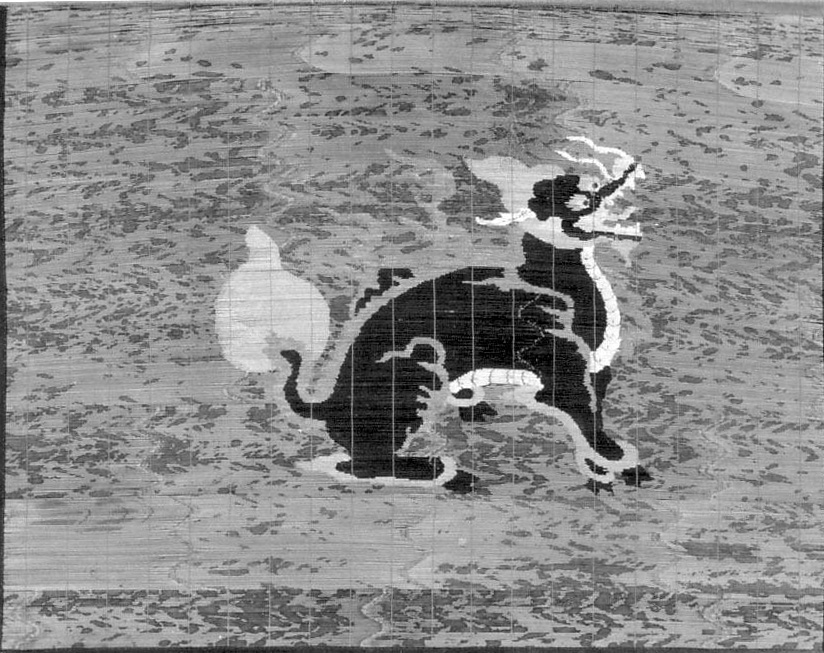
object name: blind with covered box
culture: chinese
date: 1701-1900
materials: bamboo, silk, wood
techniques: lacquer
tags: mythical creatures